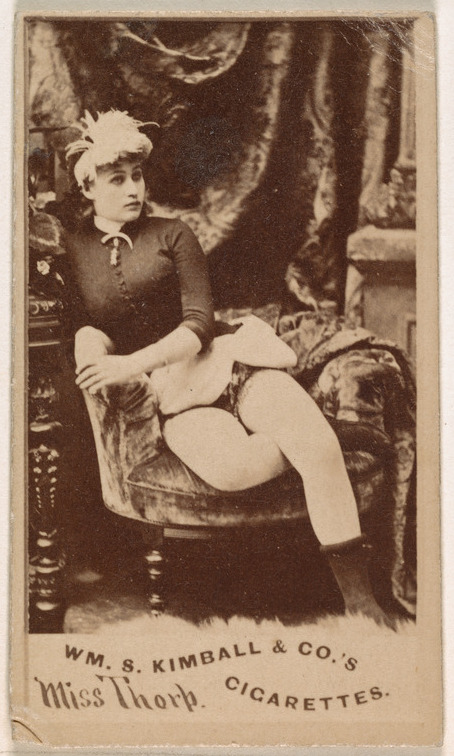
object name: photograph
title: Miss Thorp, from the Actresses series (N203) issued by Wm. S. Kimball & Co.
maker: william s. kimball & company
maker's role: publisher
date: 1889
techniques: color lithograph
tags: portraits,women,actresses